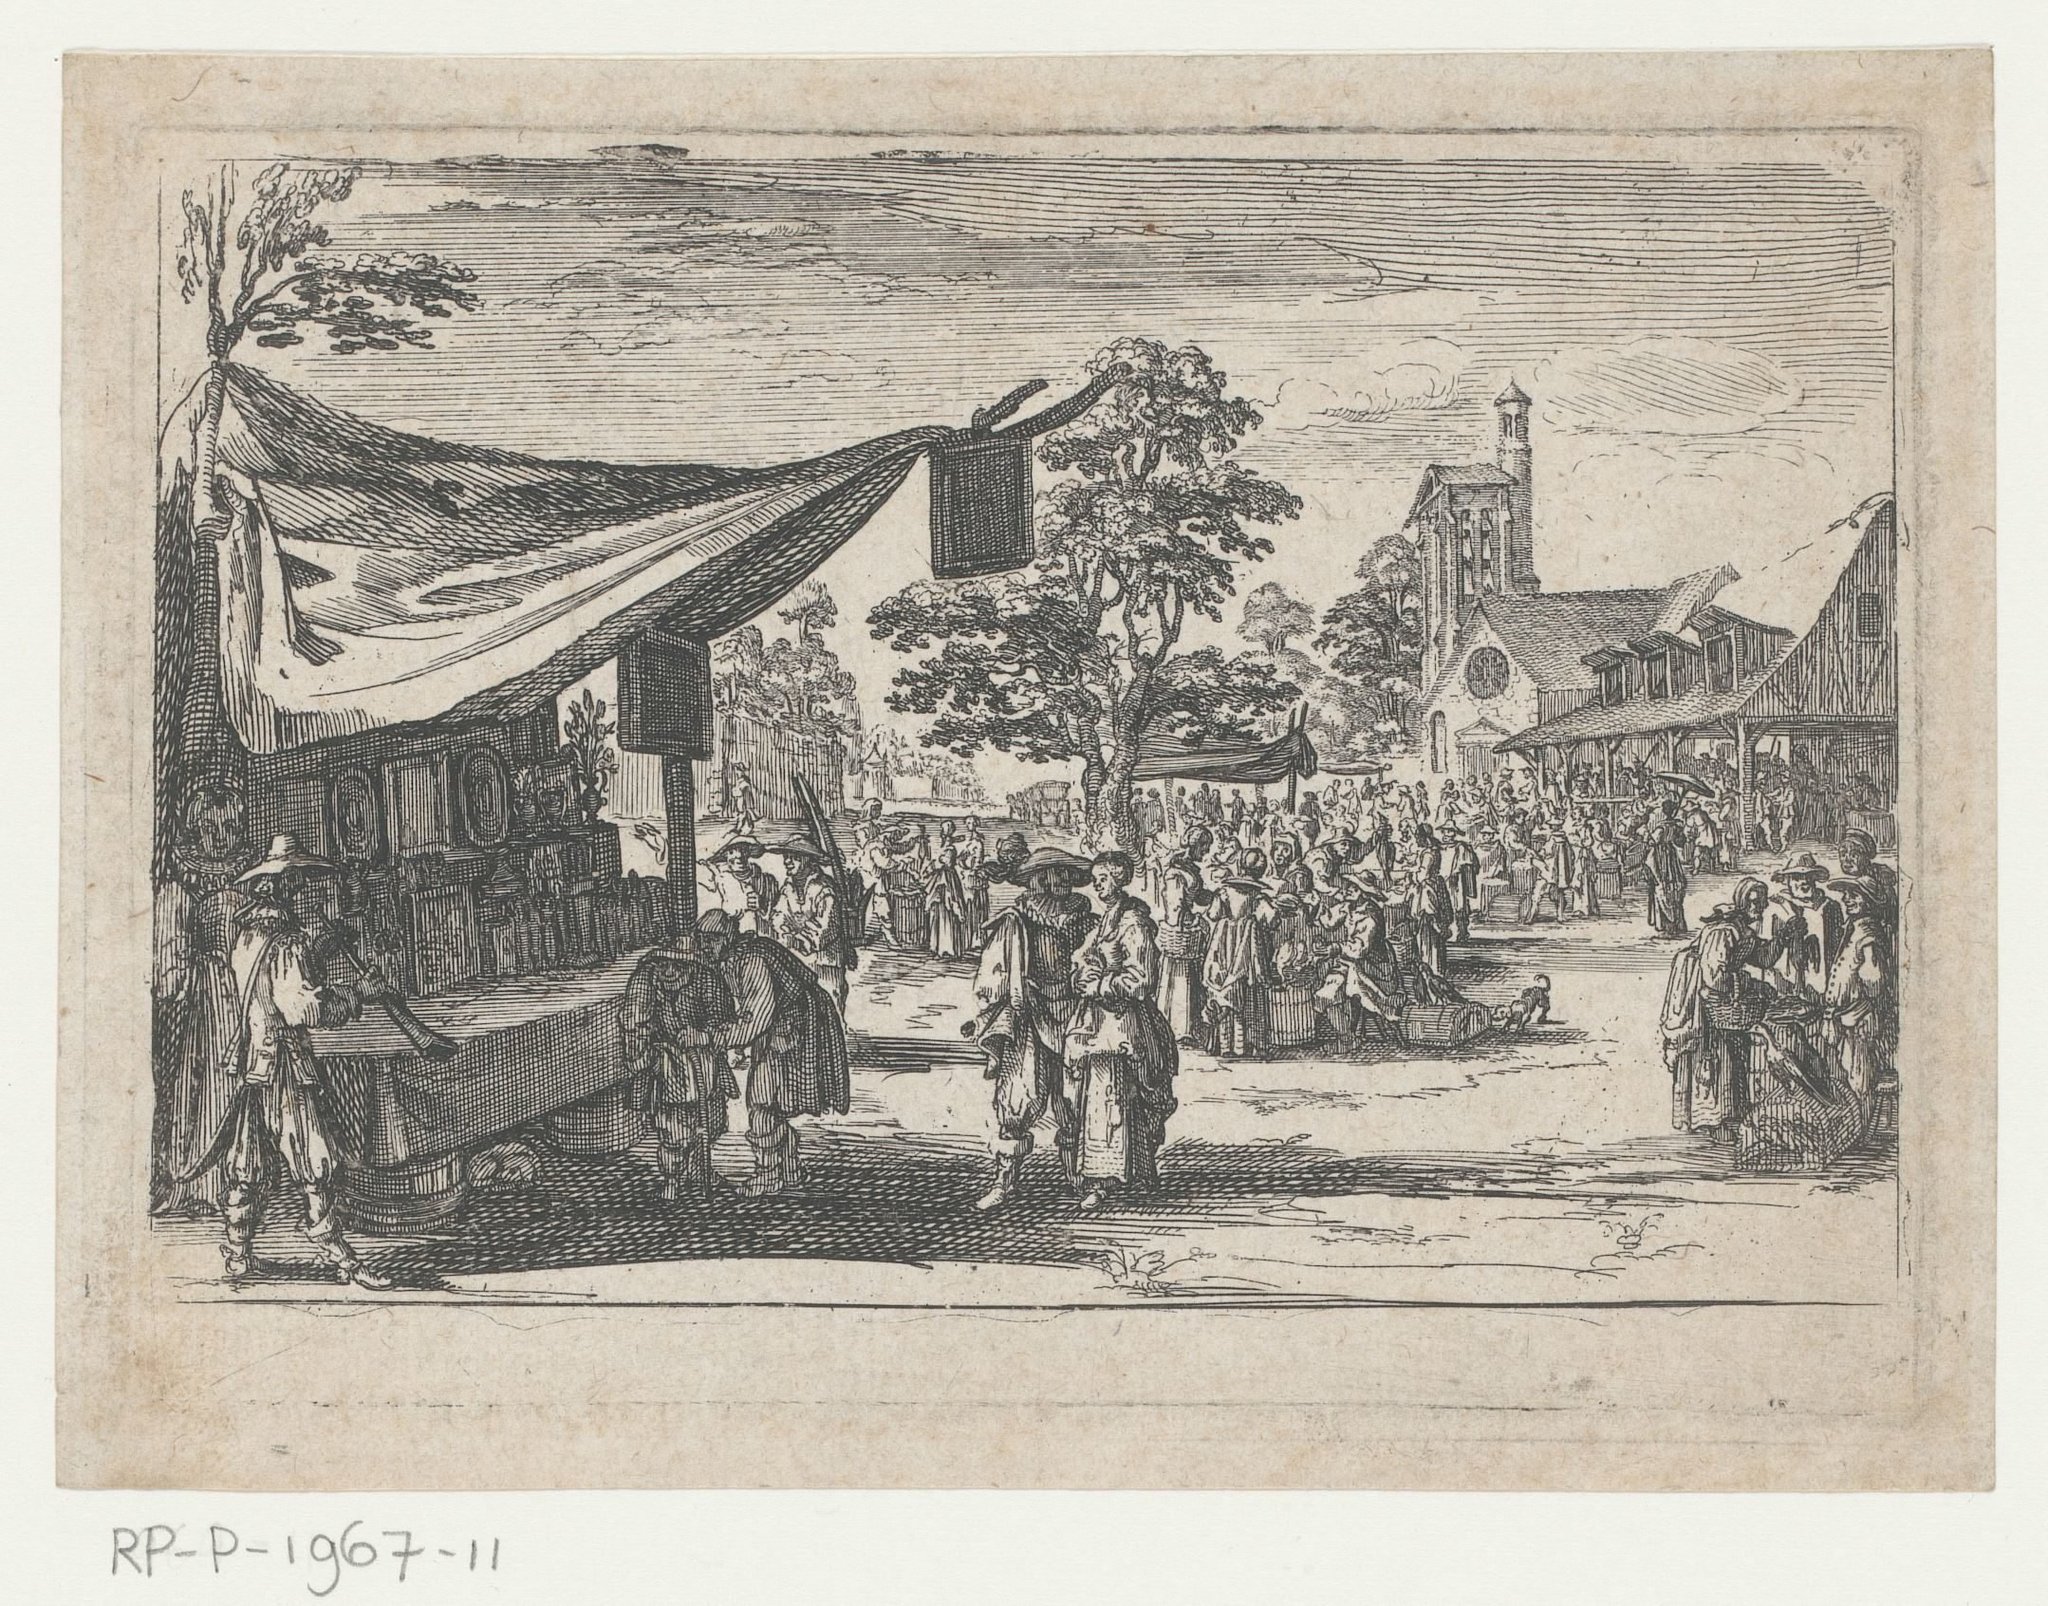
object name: print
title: Markttafereel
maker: nicolas de son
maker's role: print maker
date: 1611-1650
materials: paper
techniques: engraving, etching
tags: stall, booth (~ market), merchant, salesman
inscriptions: collector's mark: Lugt 2760, collector's mark: Lugt 2228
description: Gezicht op een marktplein met links vooraan een kraam met schilderijen.